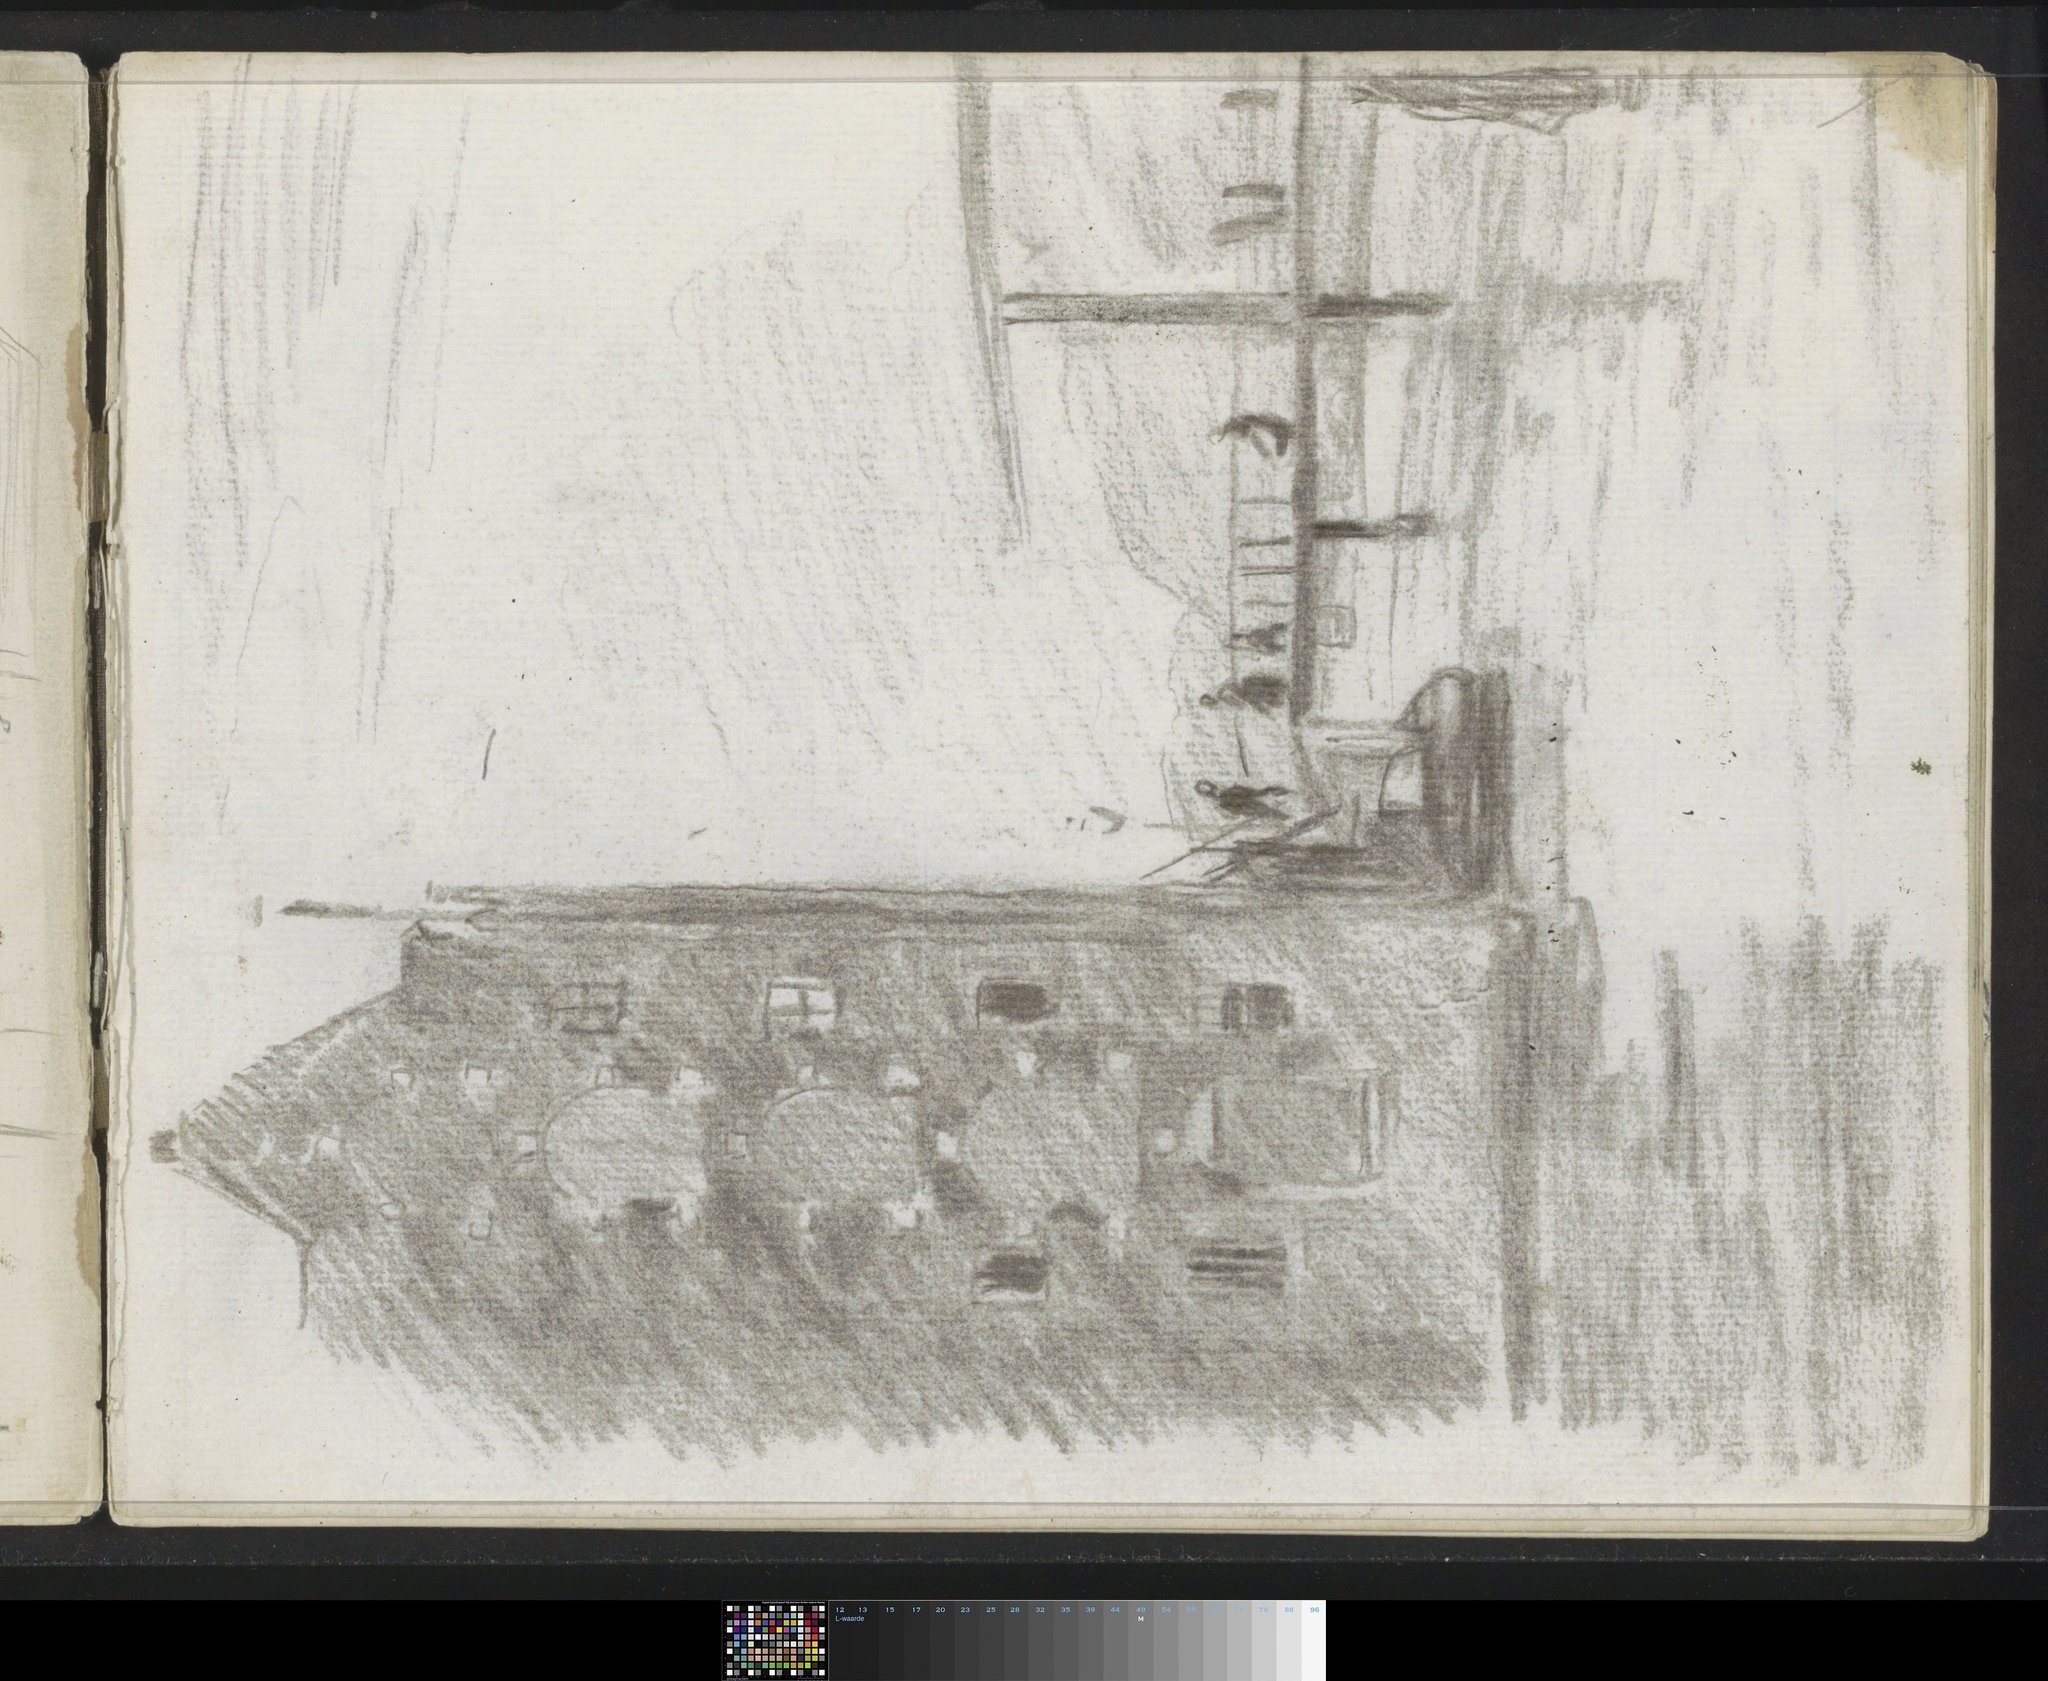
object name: sketchbook leaf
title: Voorstudie voor het schilderij Gezicht vanaf de Rapenburgwal op de Peperbrug en het pakhuis Sweeden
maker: willem witsen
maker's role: draughtsman, painter, print maker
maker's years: 1860-1923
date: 1911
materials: charcoal, paper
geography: amsterdam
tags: large-scale structure for storage, e.g.: warehouse, depot, silo, bridge in city across river, canal, etc.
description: Gezien van de Rapenburgwal naar de brug tussen Rapenburg en Uilenburg. Het pakhuis, 'Sweeden' geheten, staat op de hoek van de Uilenburgwal en de Rapenburgwal. Pagina 9 uit een schetsboek met 18 bladen.